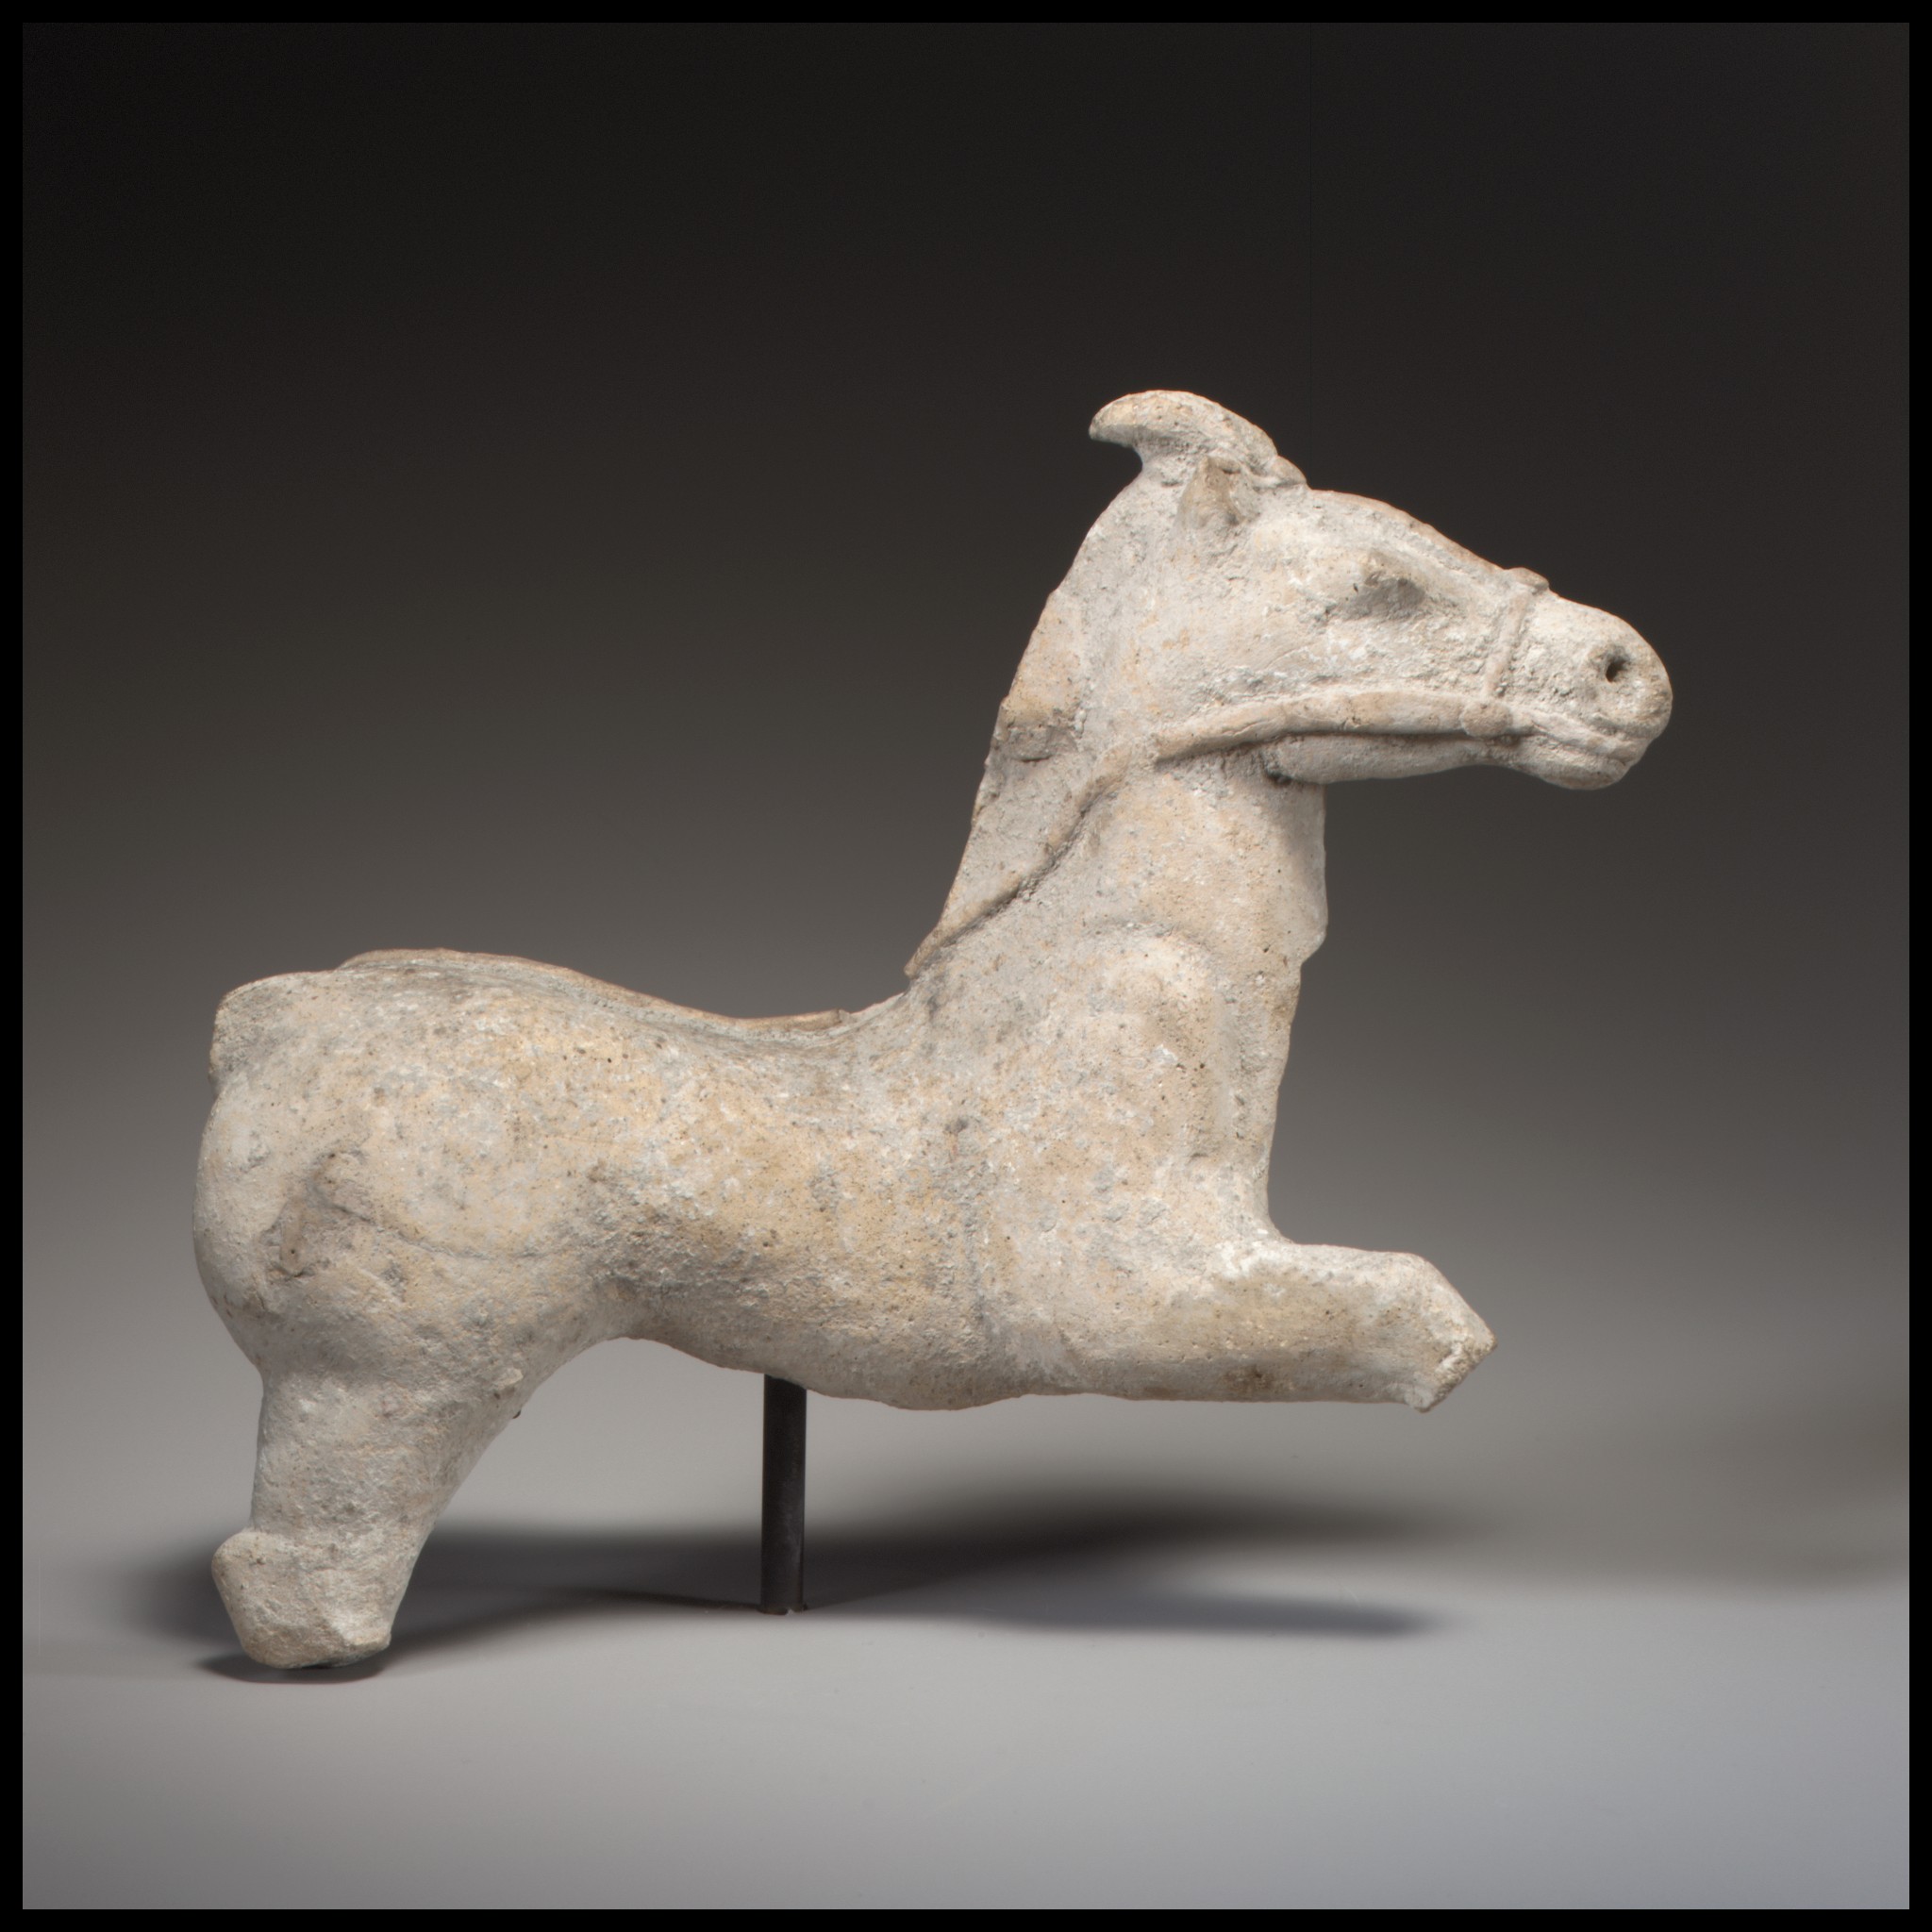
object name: statuette of a horse from chariot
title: Terracotta statuette of a horse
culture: cypriot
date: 334-301 BCE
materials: terracotta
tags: horses